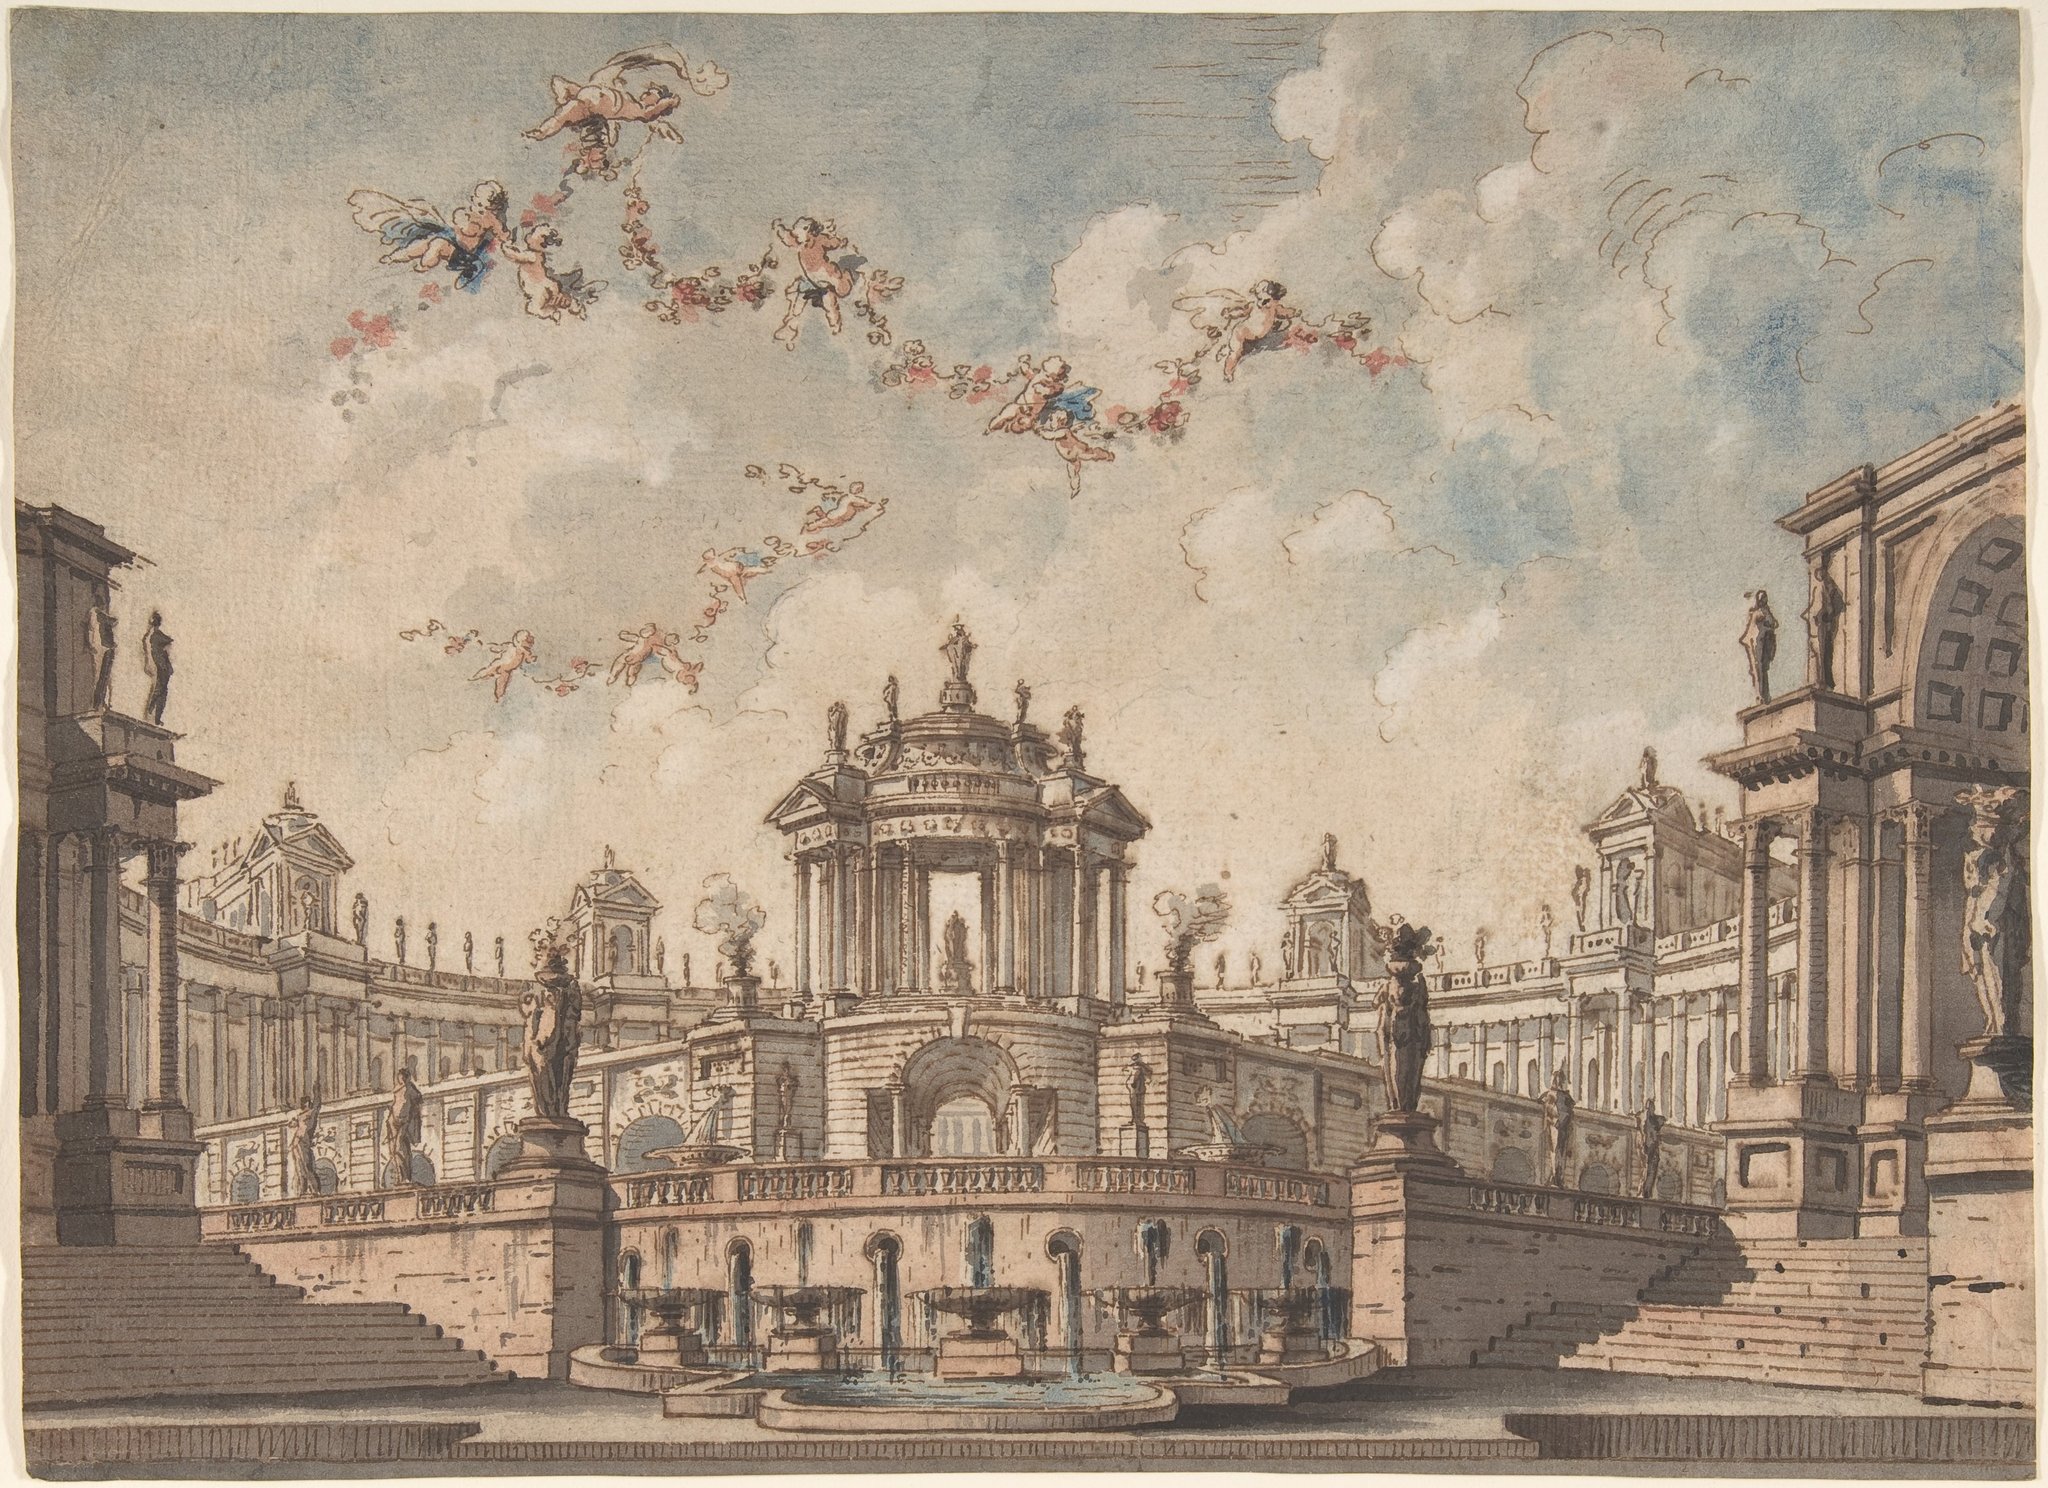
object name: drawing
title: Design for a Stage Set: Semi-Circular Colonnaded Building, a Bridge Surmounted by a Tempietto, a Fountain in the Foreground and Putti Bearing Garlands.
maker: antonio basoli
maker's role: artist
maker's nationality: italian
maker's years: 1774-1843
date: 1774-1843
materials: graphite, ink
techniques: brush, pen, wash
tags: buildings,fountains,stage design